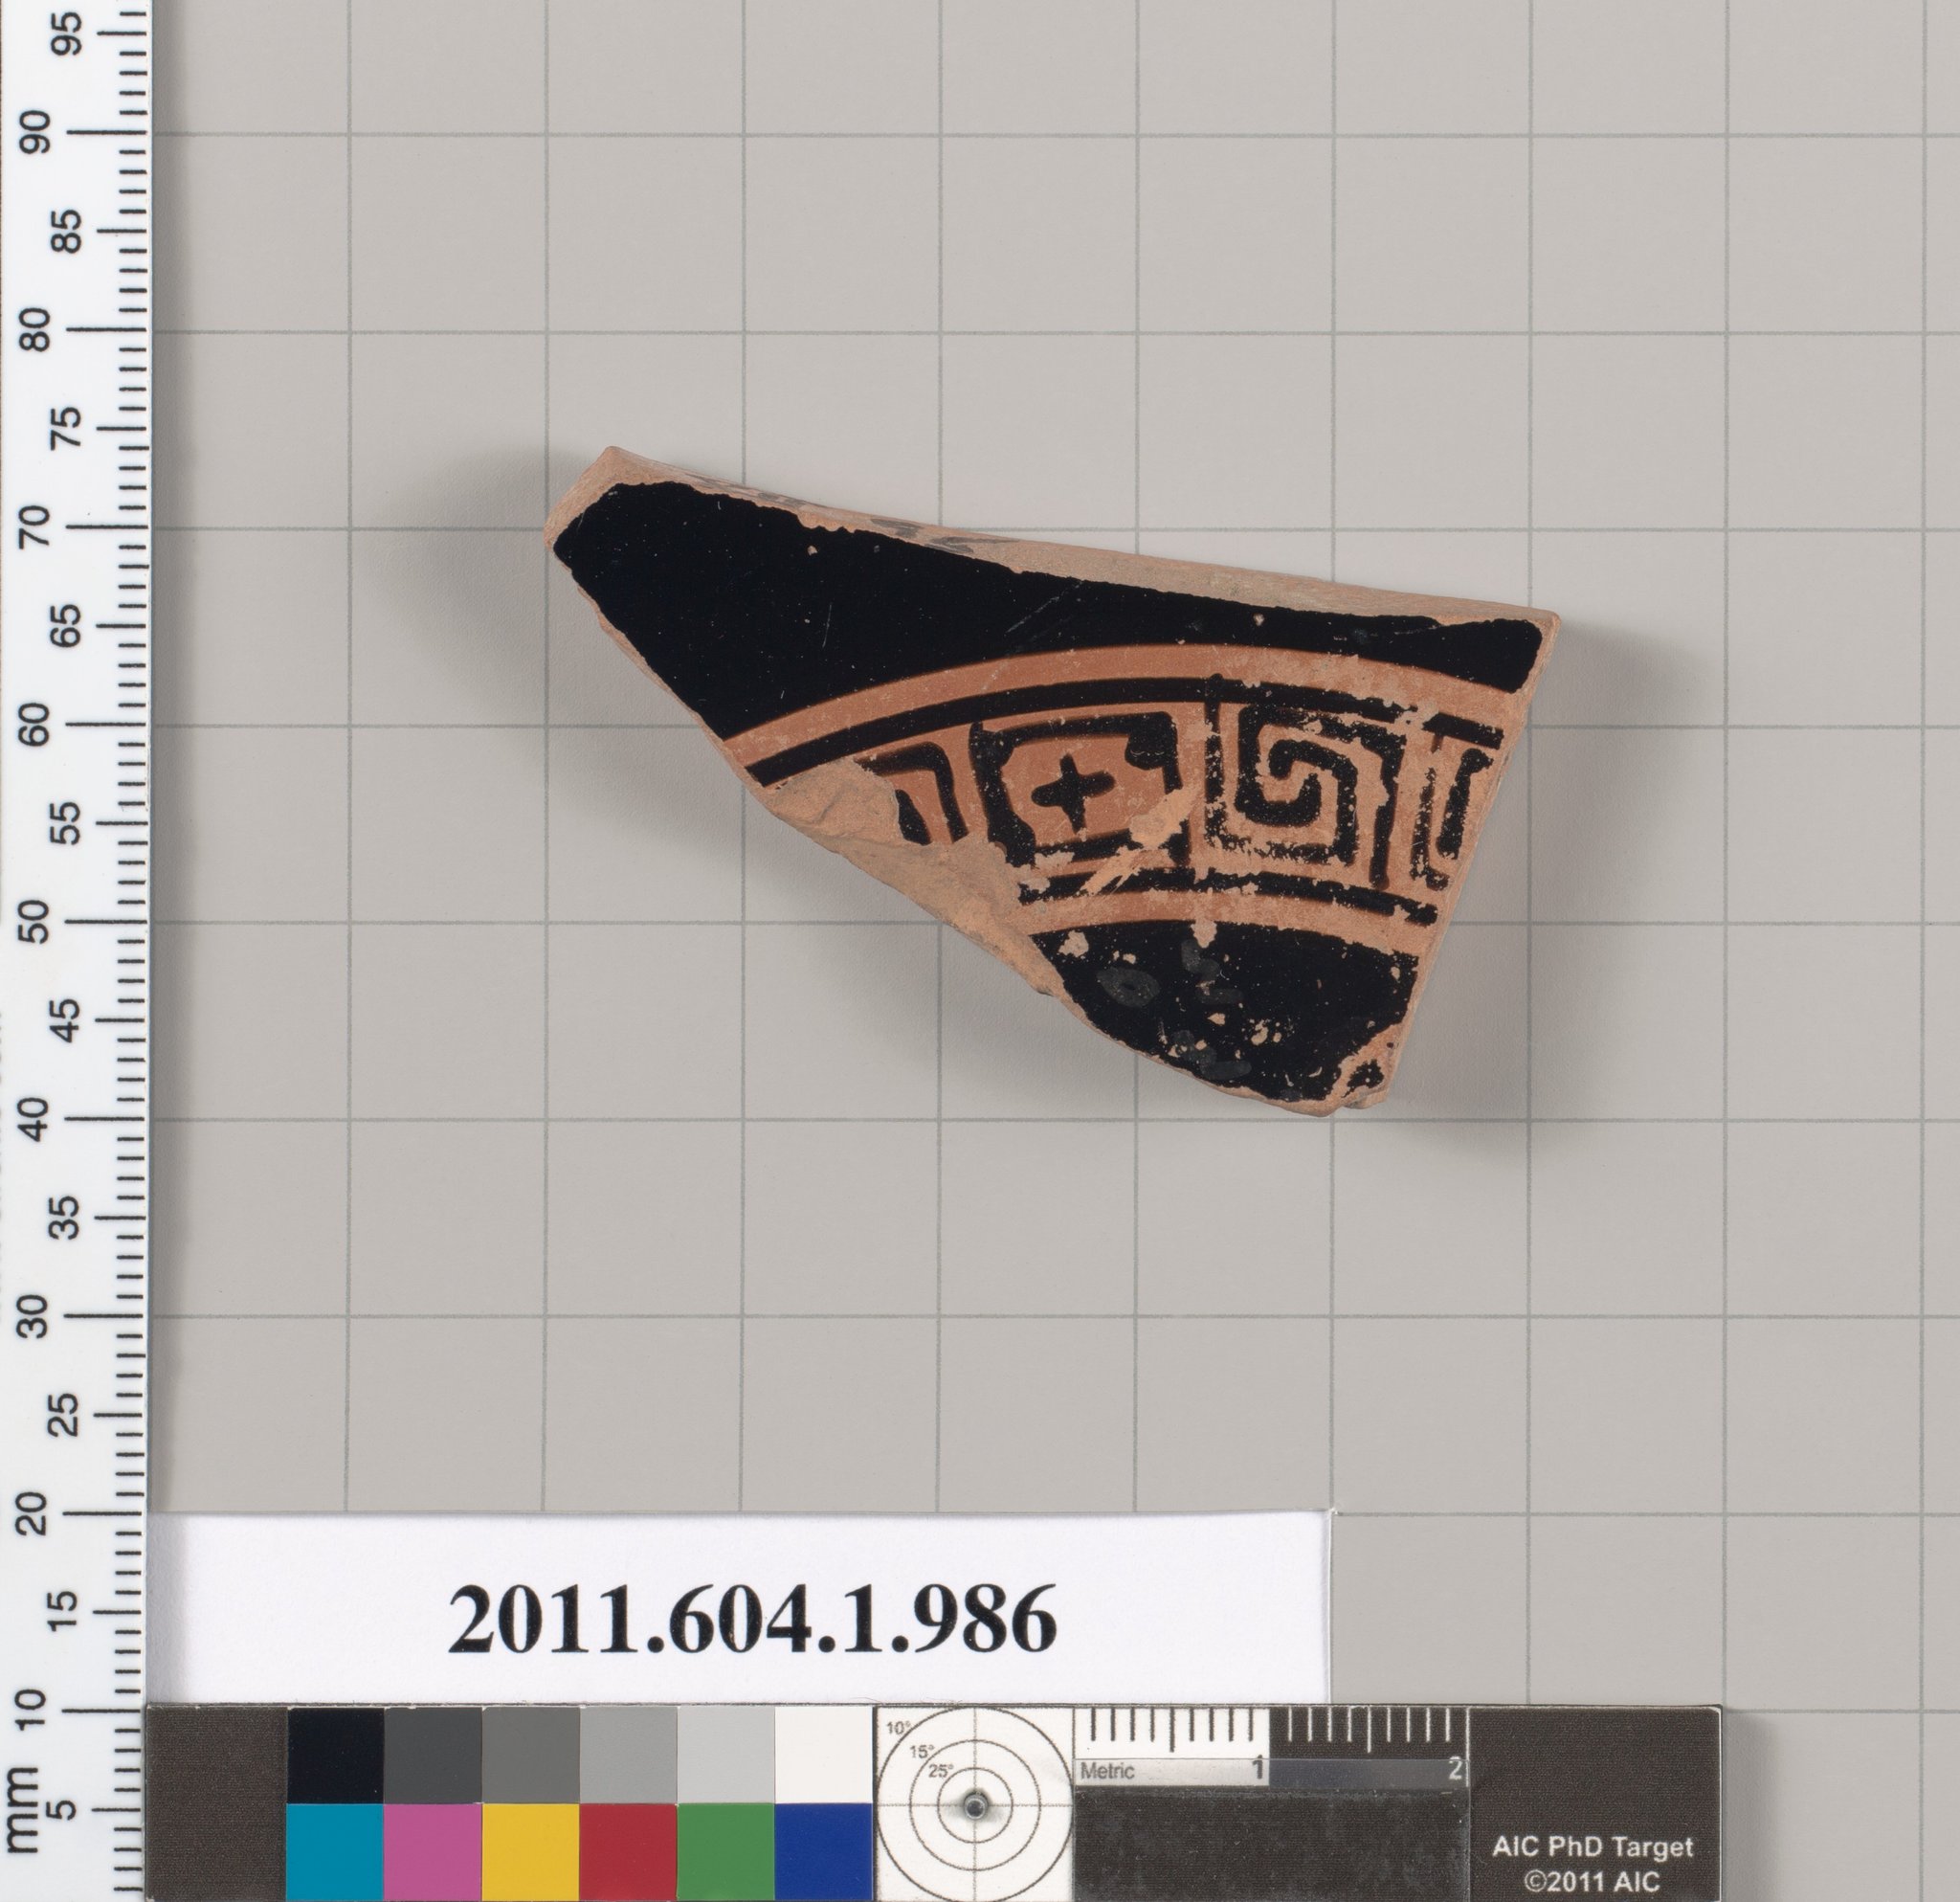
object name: kylix fragment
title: Terracotta fragment of a kylix (drinking cup)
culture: greek, attic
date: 475-451 BCE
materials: terracotta